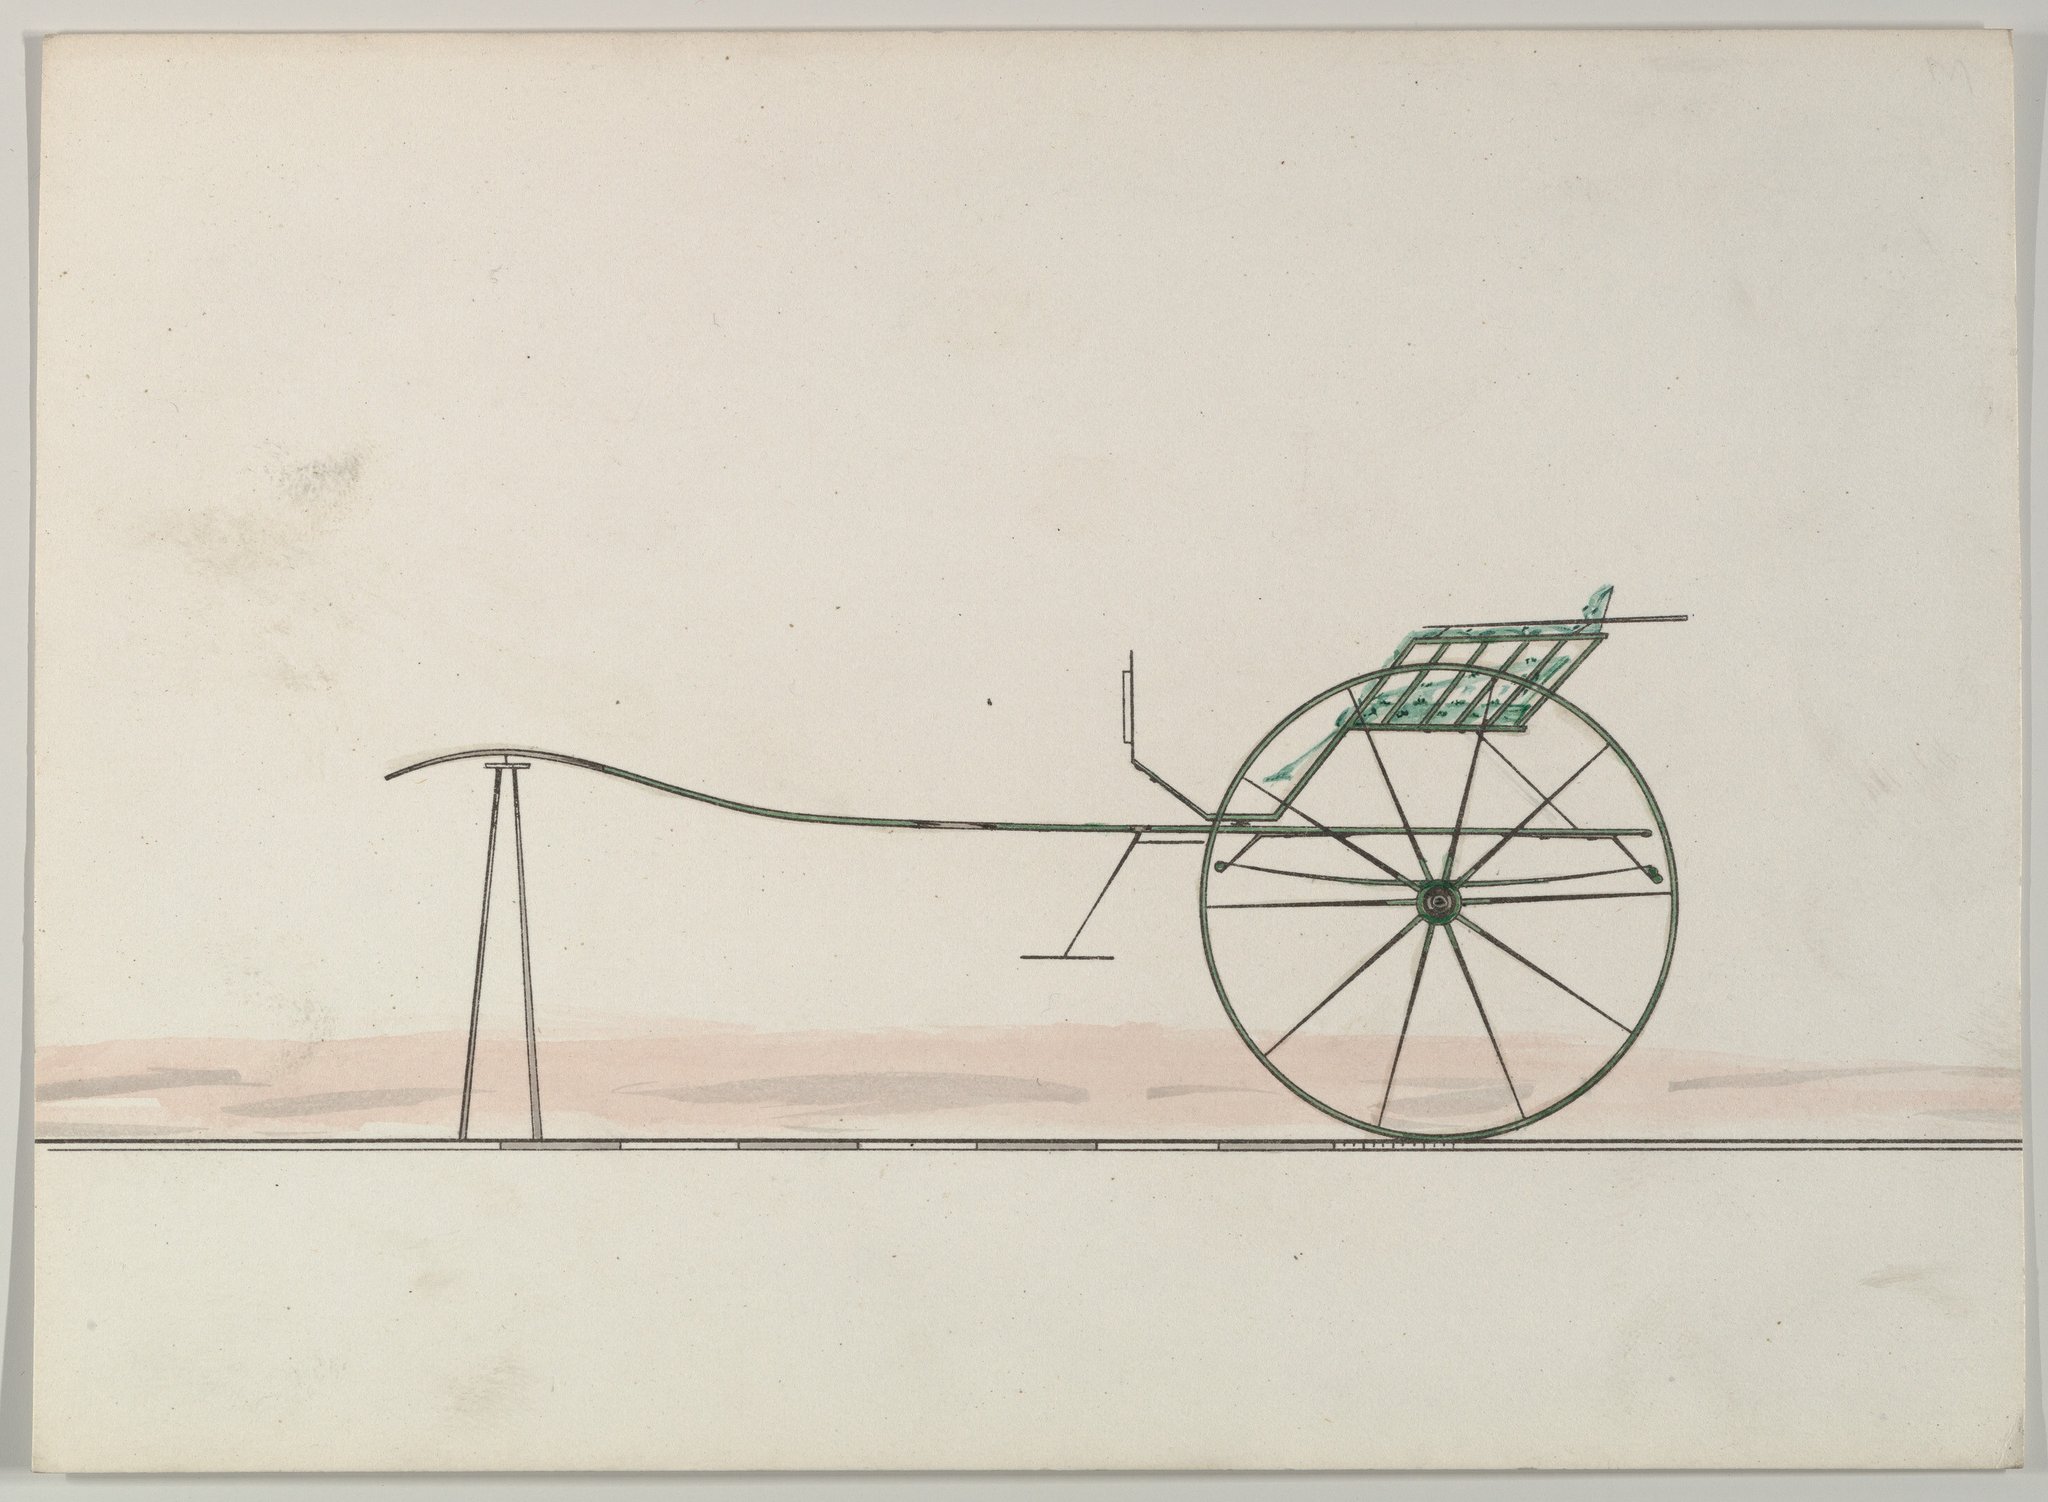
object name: drawing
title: Gig (unnumbered)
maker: brewster & co.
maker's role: manufacturer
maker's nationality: american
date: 1850-1874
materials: ink, watercolor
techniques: pen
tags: carriages